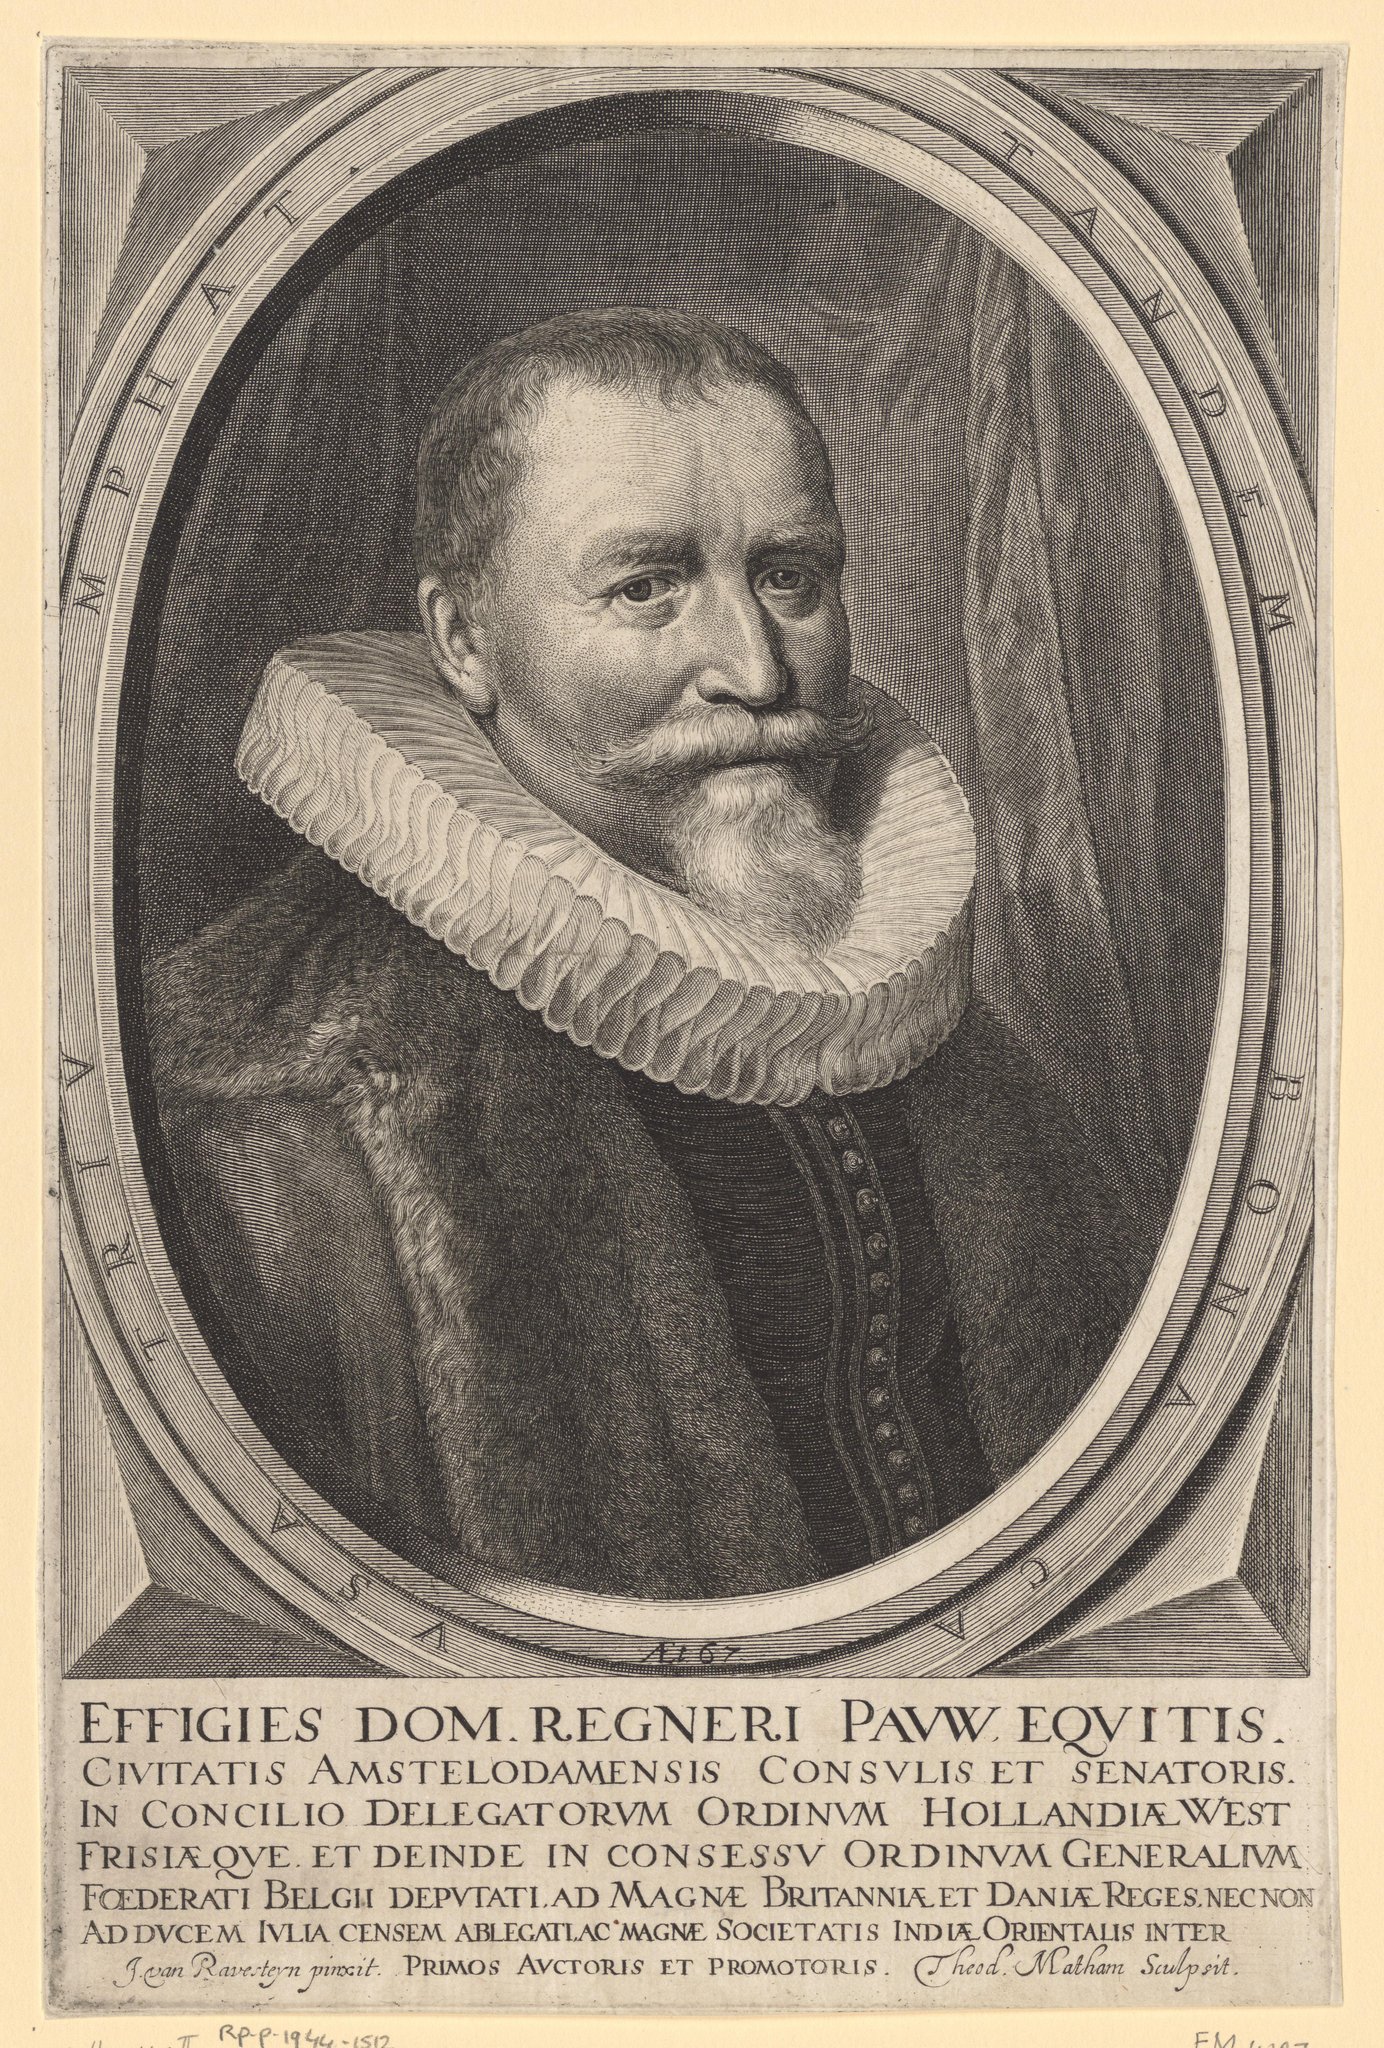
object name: print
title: Portret van Reinier Adriaensz. Pauw op 67-jarige leeftijd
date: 1631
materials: paper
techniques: engraving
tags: amsterdam, mayor, adult man, historical persons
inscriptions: collector's mark: Lugt 2228